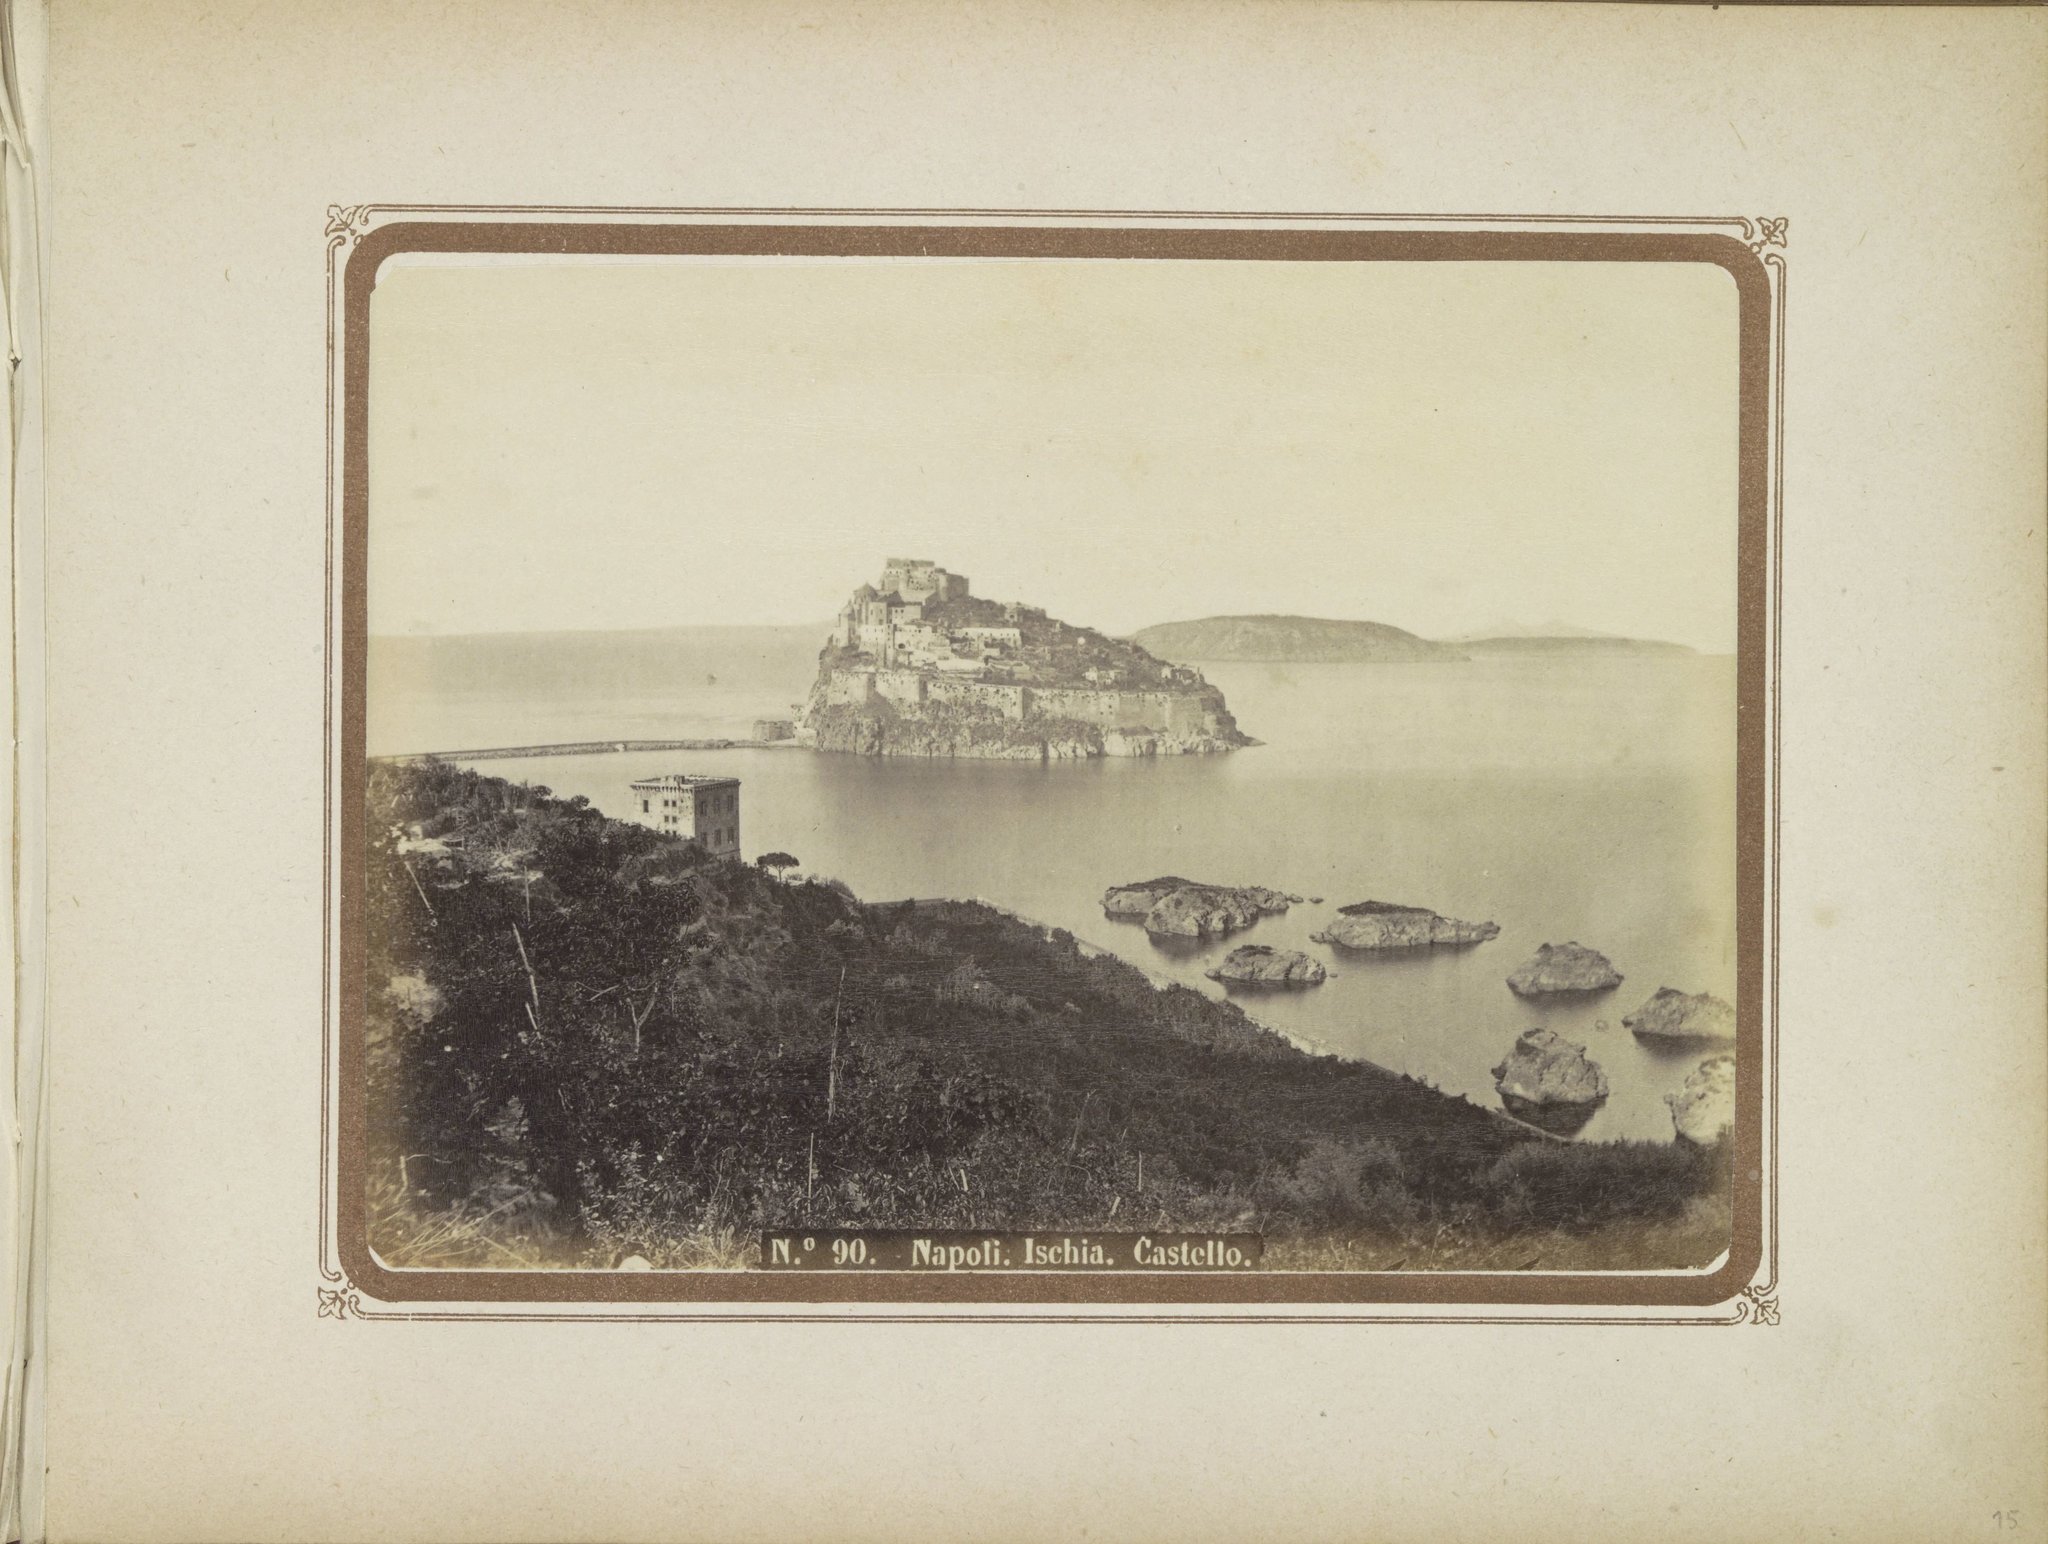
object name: album leaf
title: Gezicht op het eiland Ischia met het Castello Aragonese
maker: roberto rive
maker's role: fotograaf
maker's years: 1825-1868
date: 1860-1900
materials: paper, photographic support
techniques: albumen print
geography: naples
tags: island, castle, ischia, isola d'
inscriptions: number: ‘90’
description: Onderdeel van Fotoalbum met bezienswaardigheden in Napels en omgeving door Roberto Rive.